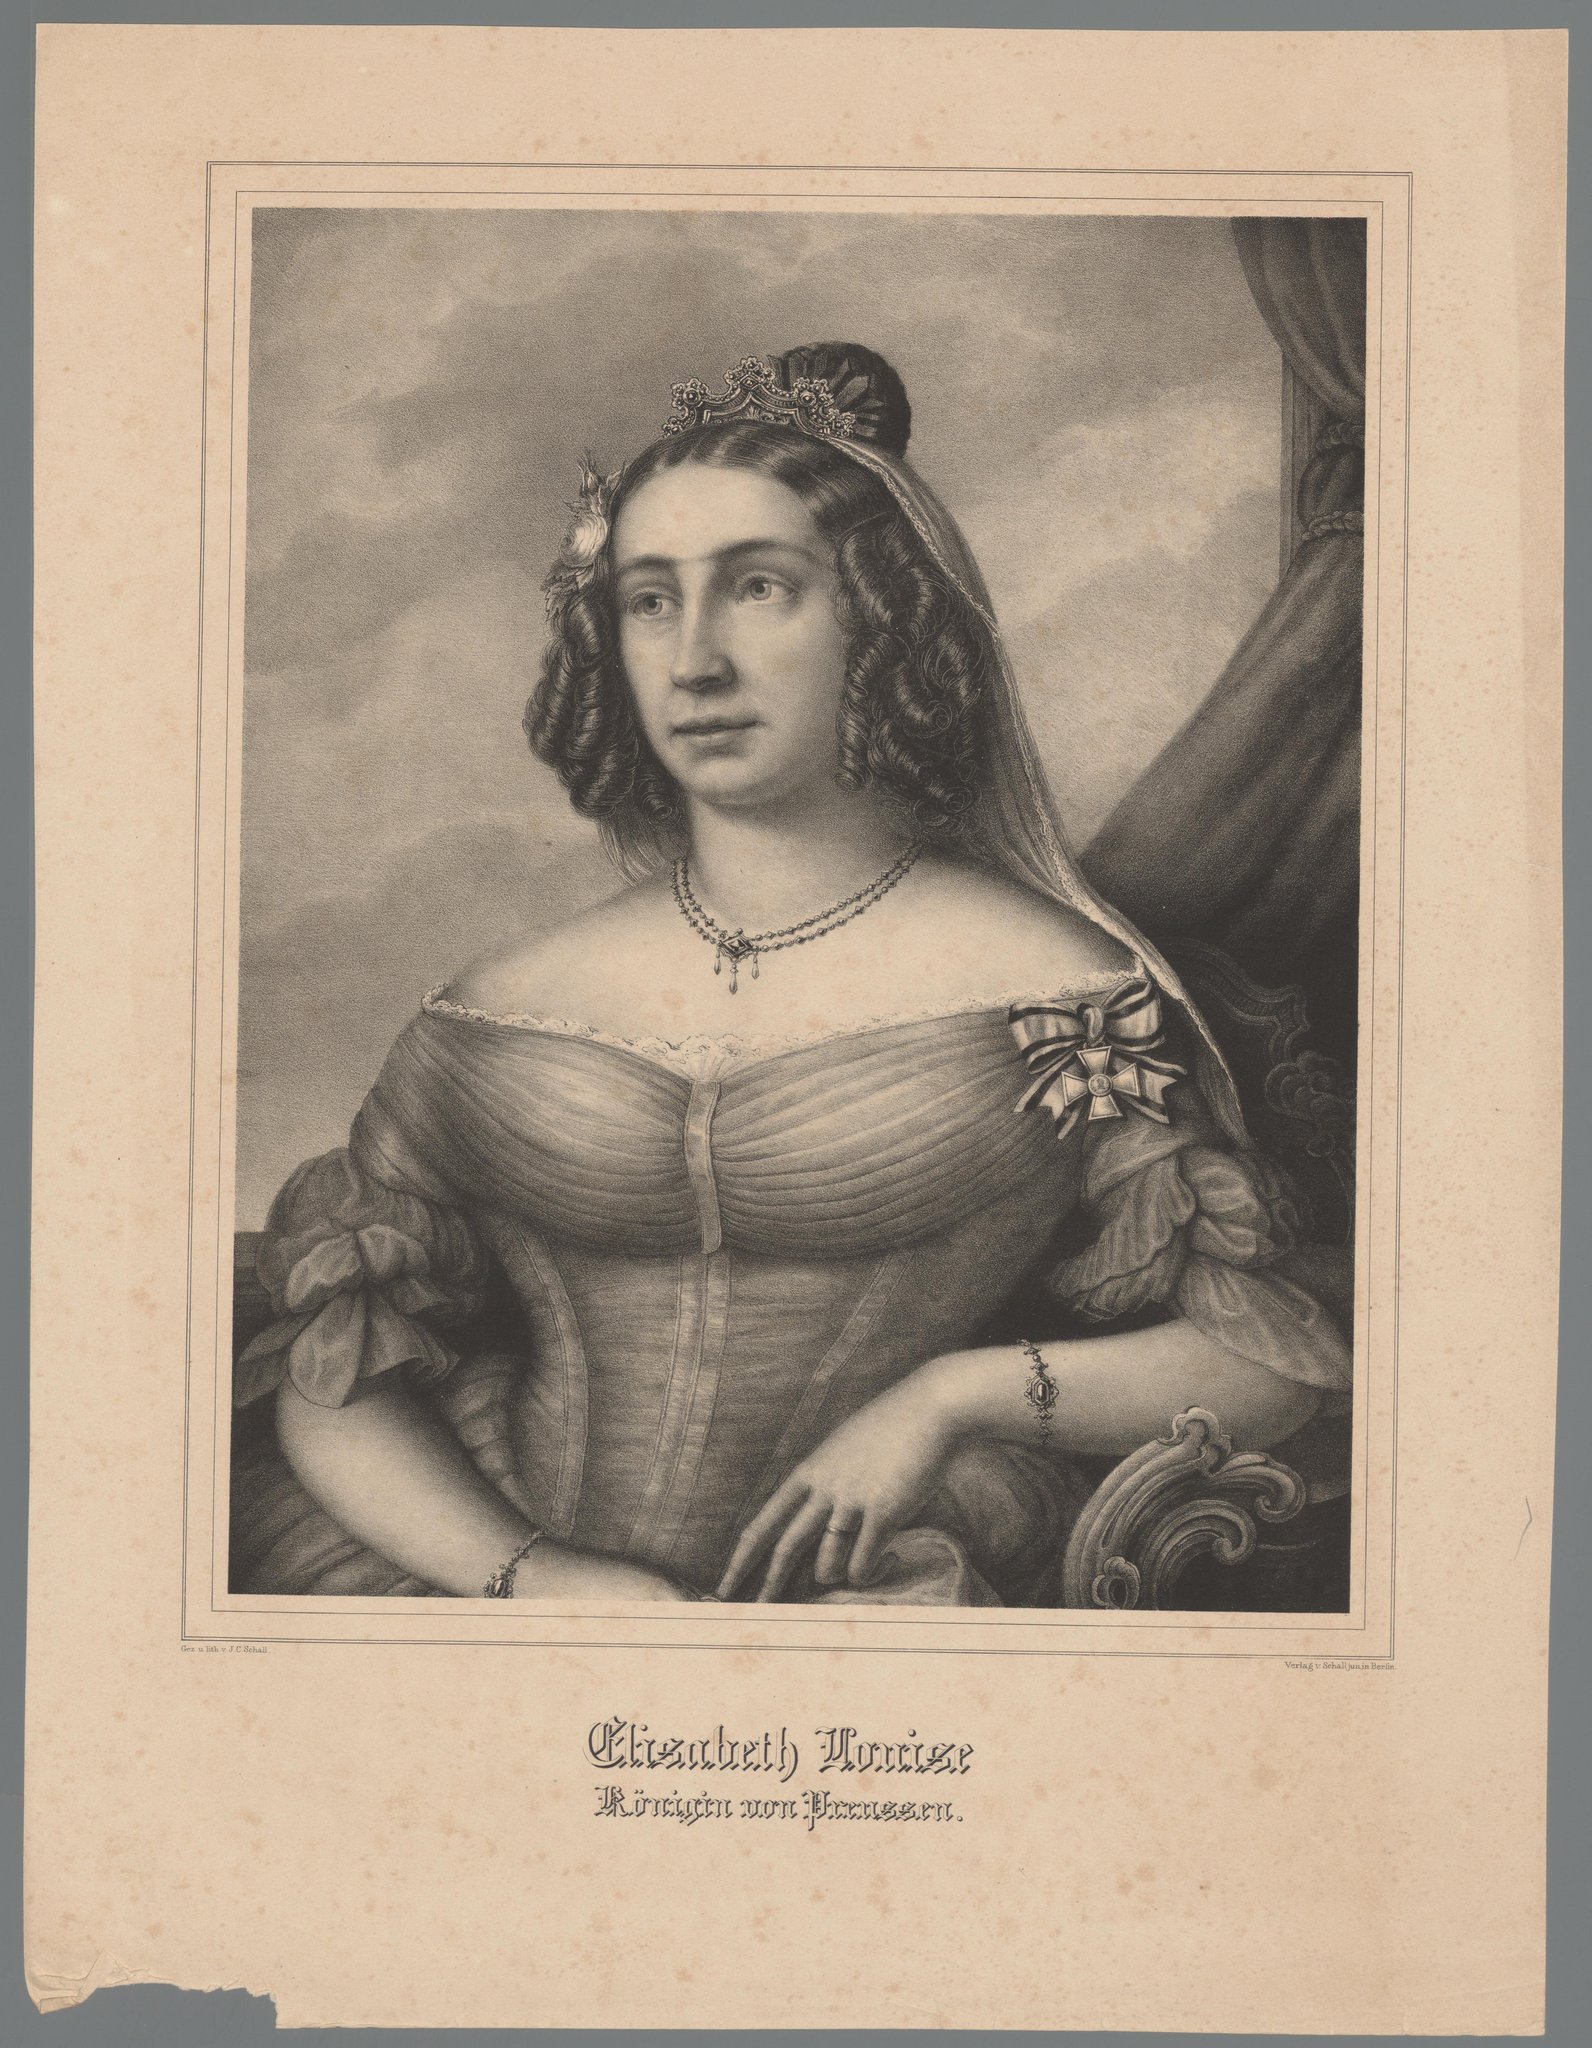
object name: print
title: Elisabeth Louise Königin von Preussen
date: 1840-1865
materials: paper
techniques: lithograph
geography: berlin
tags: adult woman, historical persons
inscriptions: collector's mark: Lugt 2228